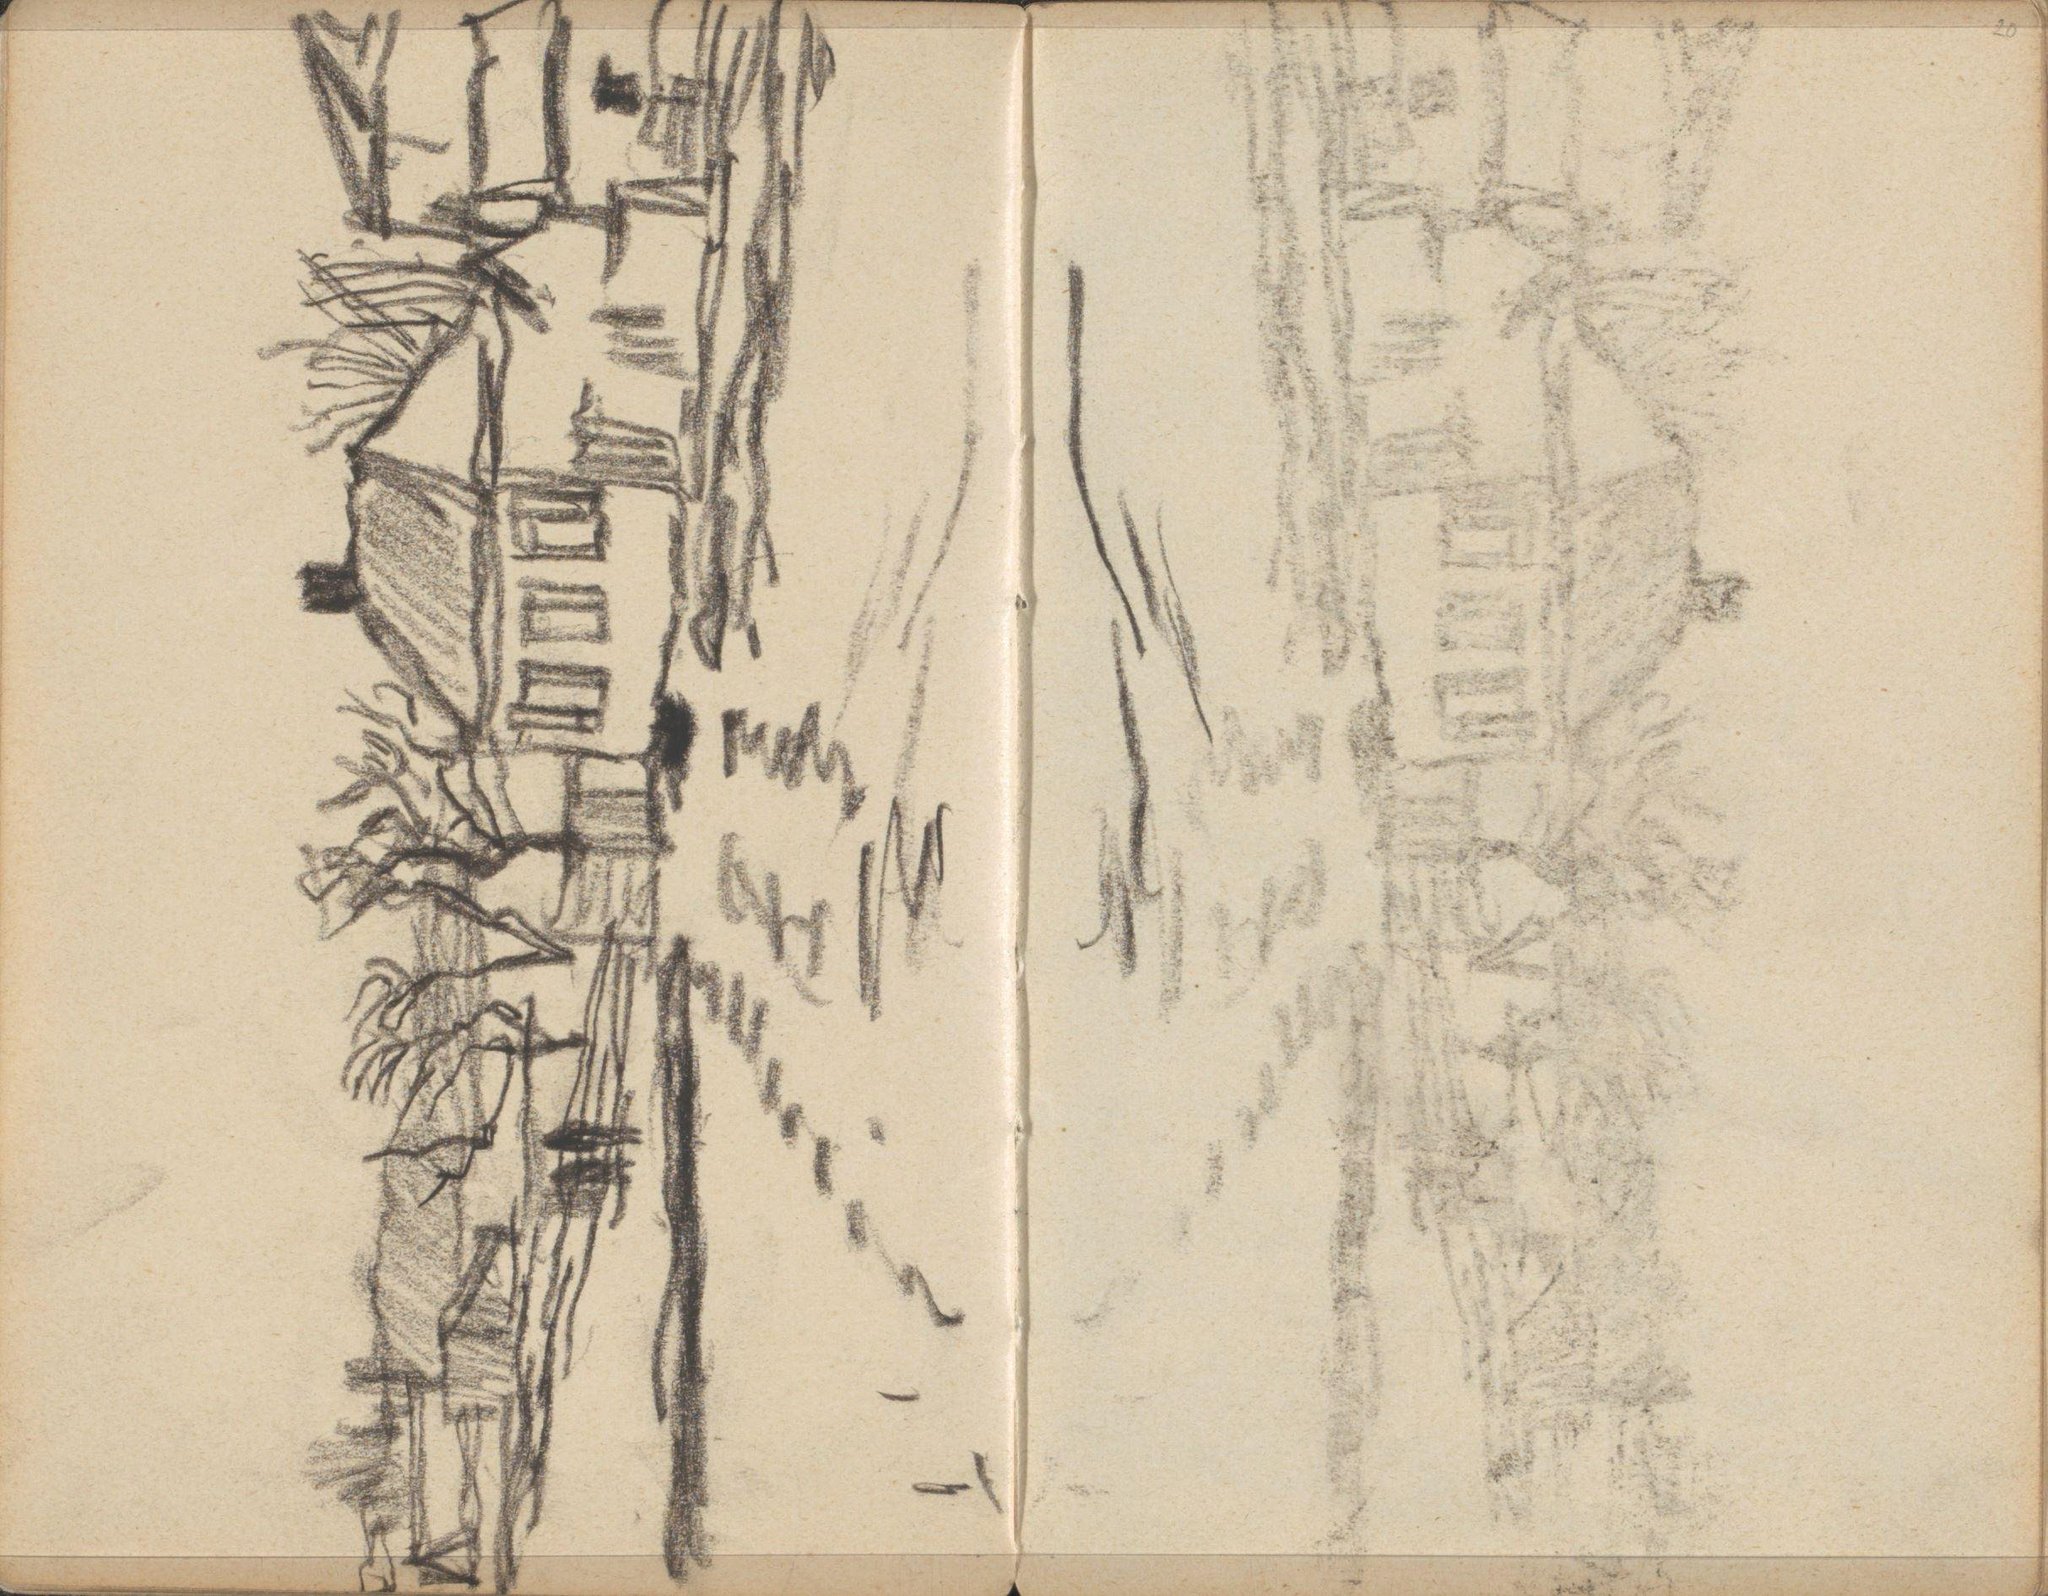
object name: sketchbook leaf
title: Landschap met bebouwing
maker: george hendrik breitner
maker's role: draughtsman, painter, print maker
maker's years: 1857-1923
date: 1910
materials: chalk, paper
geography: north holland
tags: landscapes, rural housing, e.g. country-house, villa, cottage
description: Pagina 19 en pagina 20 uit een schetsboek met 45 bladen.